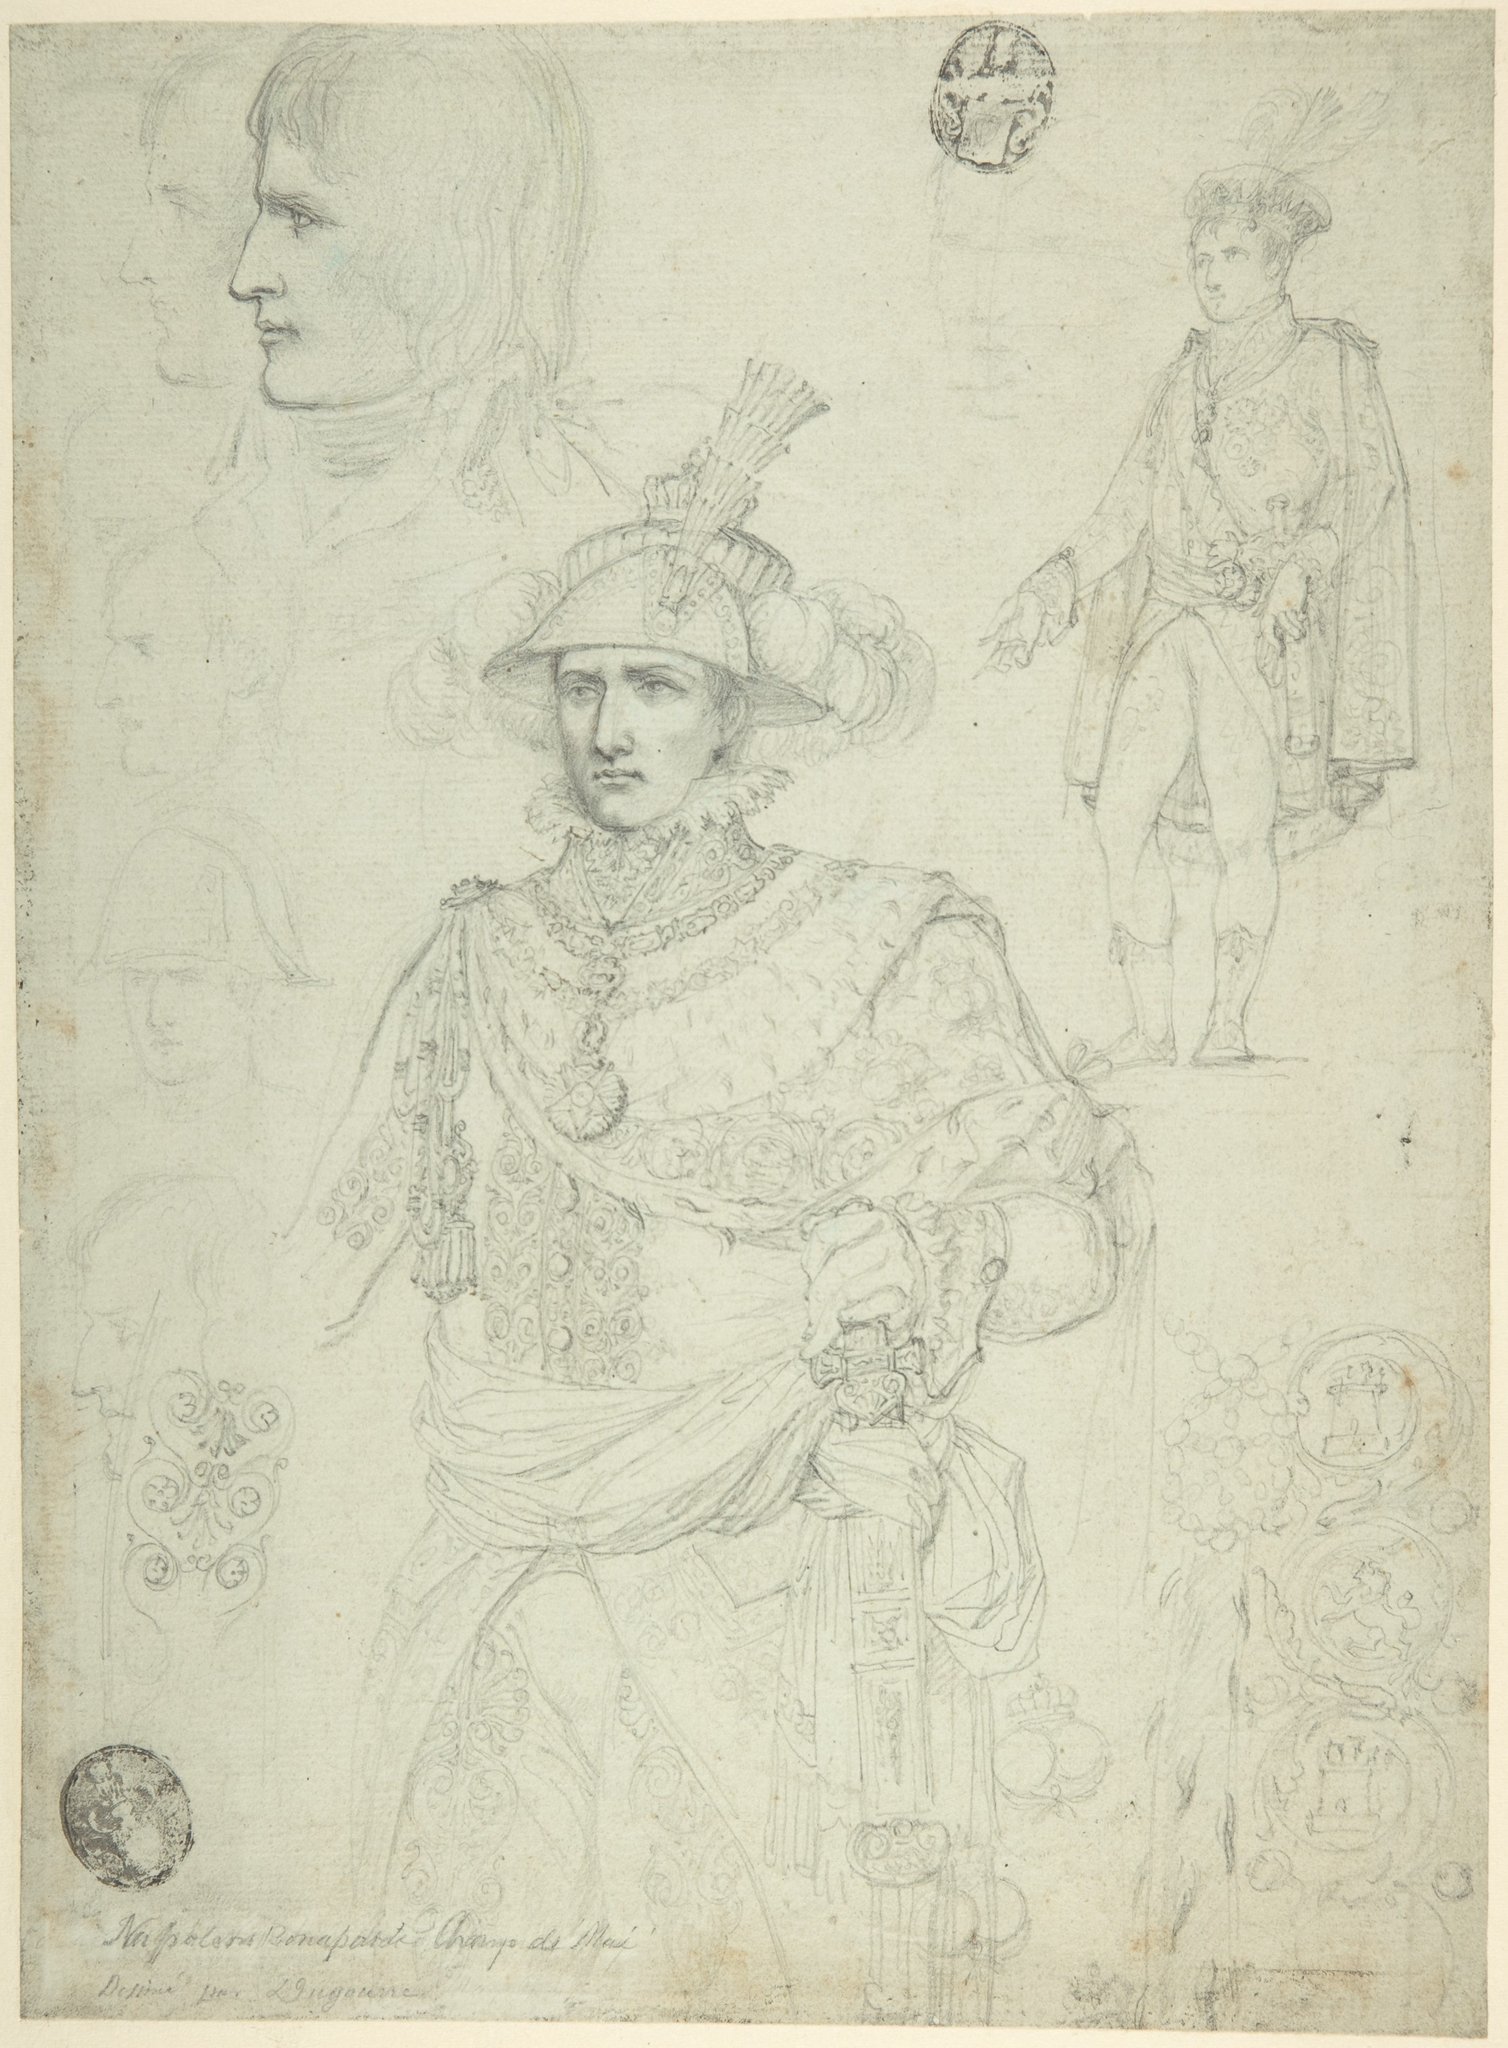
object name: drawing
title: Napoleon Bonaparte at the Champ de Mai, June 1, 1815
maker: jean démosthène dugourc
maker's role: designer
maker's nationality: french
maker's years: 1749-1825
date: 1815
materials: graphite, paper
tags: historical figures,men